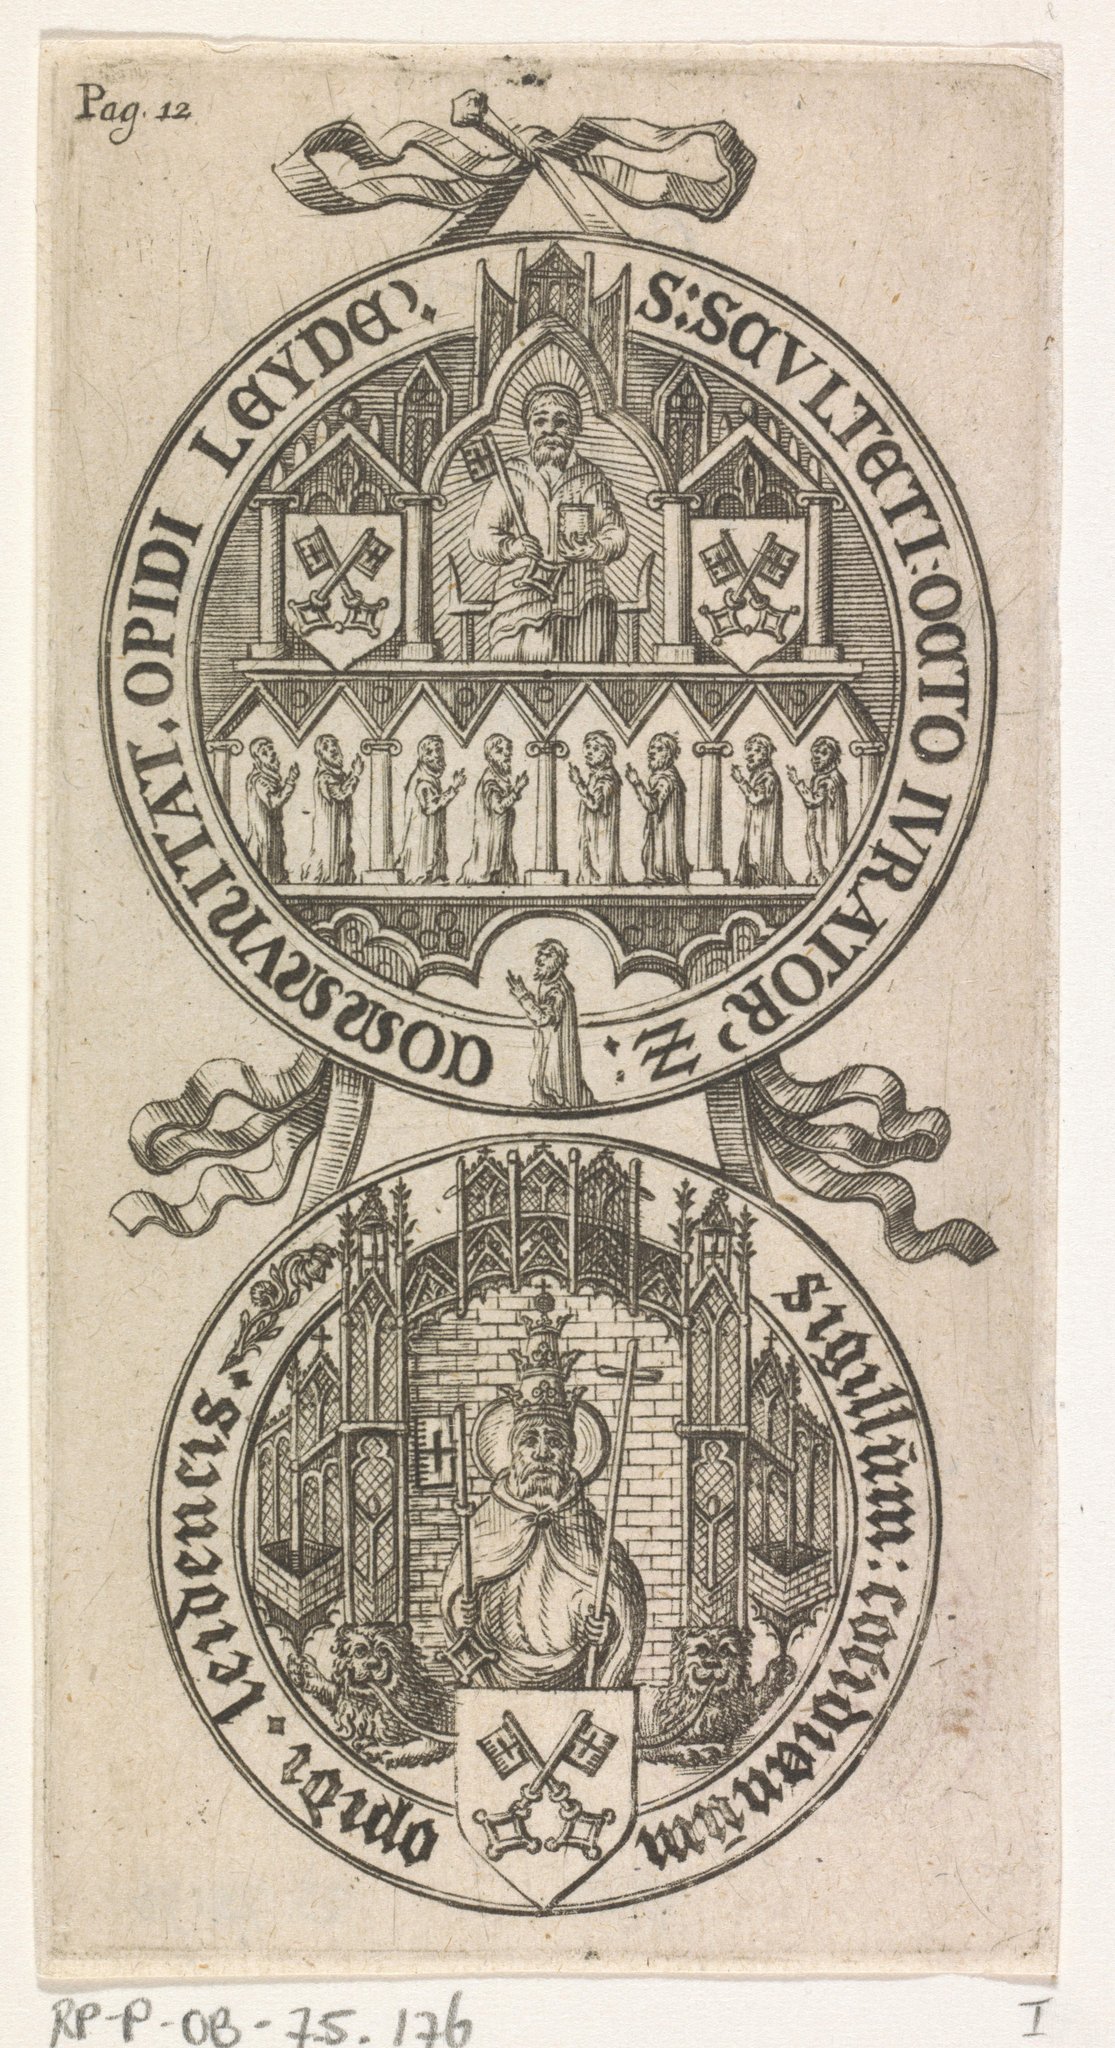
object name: book illustration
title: Stadszegel van Leiden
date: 1710-1712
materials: paper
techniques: engraving, etching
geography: leiden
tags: seal (as symbol of the state, etc.) (+ city; municipal), leiden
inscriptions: collector's mark: Lugt 240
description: De voor- en achterzijde van een stadszegel van Leiden (ca. 1293). Boven: het stadszegel van Leiden met centraal de Heilige Petrus met zijn sleutel. Naast hem de dubbele sleutels als symbool voor de stad Leiden. Onder de heilige geknielde figuren. Midden onder eveneens een geknielde figuur. Rondom een randschrift in het Latijn. Onder: de Heilige Petrus in een gotisch bouwwerk geflankeerd door twee leeuwen. Midden onder de gekruiste sleutels op een wapenschild. Rondom een randschrift in het Latijn. In de linkerbovenhoek: Pag. 12.